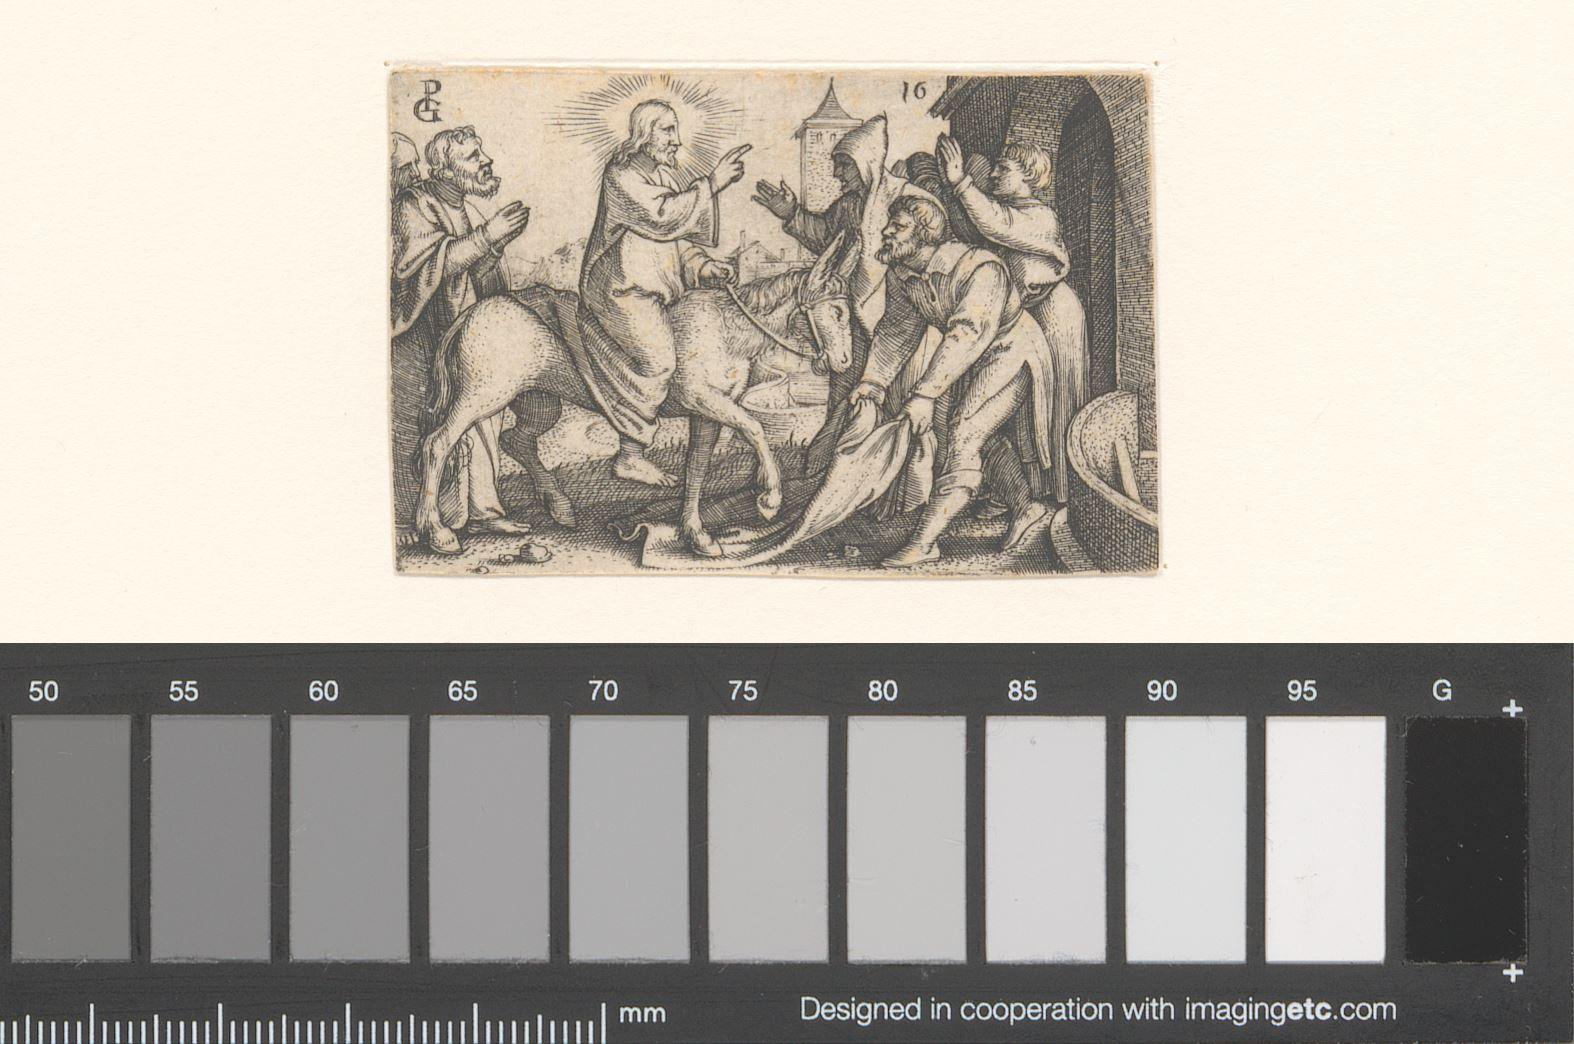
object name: print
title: Leven van Christus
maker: georg pencz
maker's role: draughtsman, painter, print maker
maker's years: 1500-1550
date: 1534-1535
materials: paper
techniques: engraving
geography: germany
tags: entry into jerusalem: people spreading their clothes before christ on the ass, and waving palm branches (matthew 21:1-11, 21:14-16; mark 11:1-11; luke 19:28-40; john 12:12-19)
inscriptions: collector's mark: Lugt 2228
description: Prent maakt deel uit van een serie van 26 prenten.